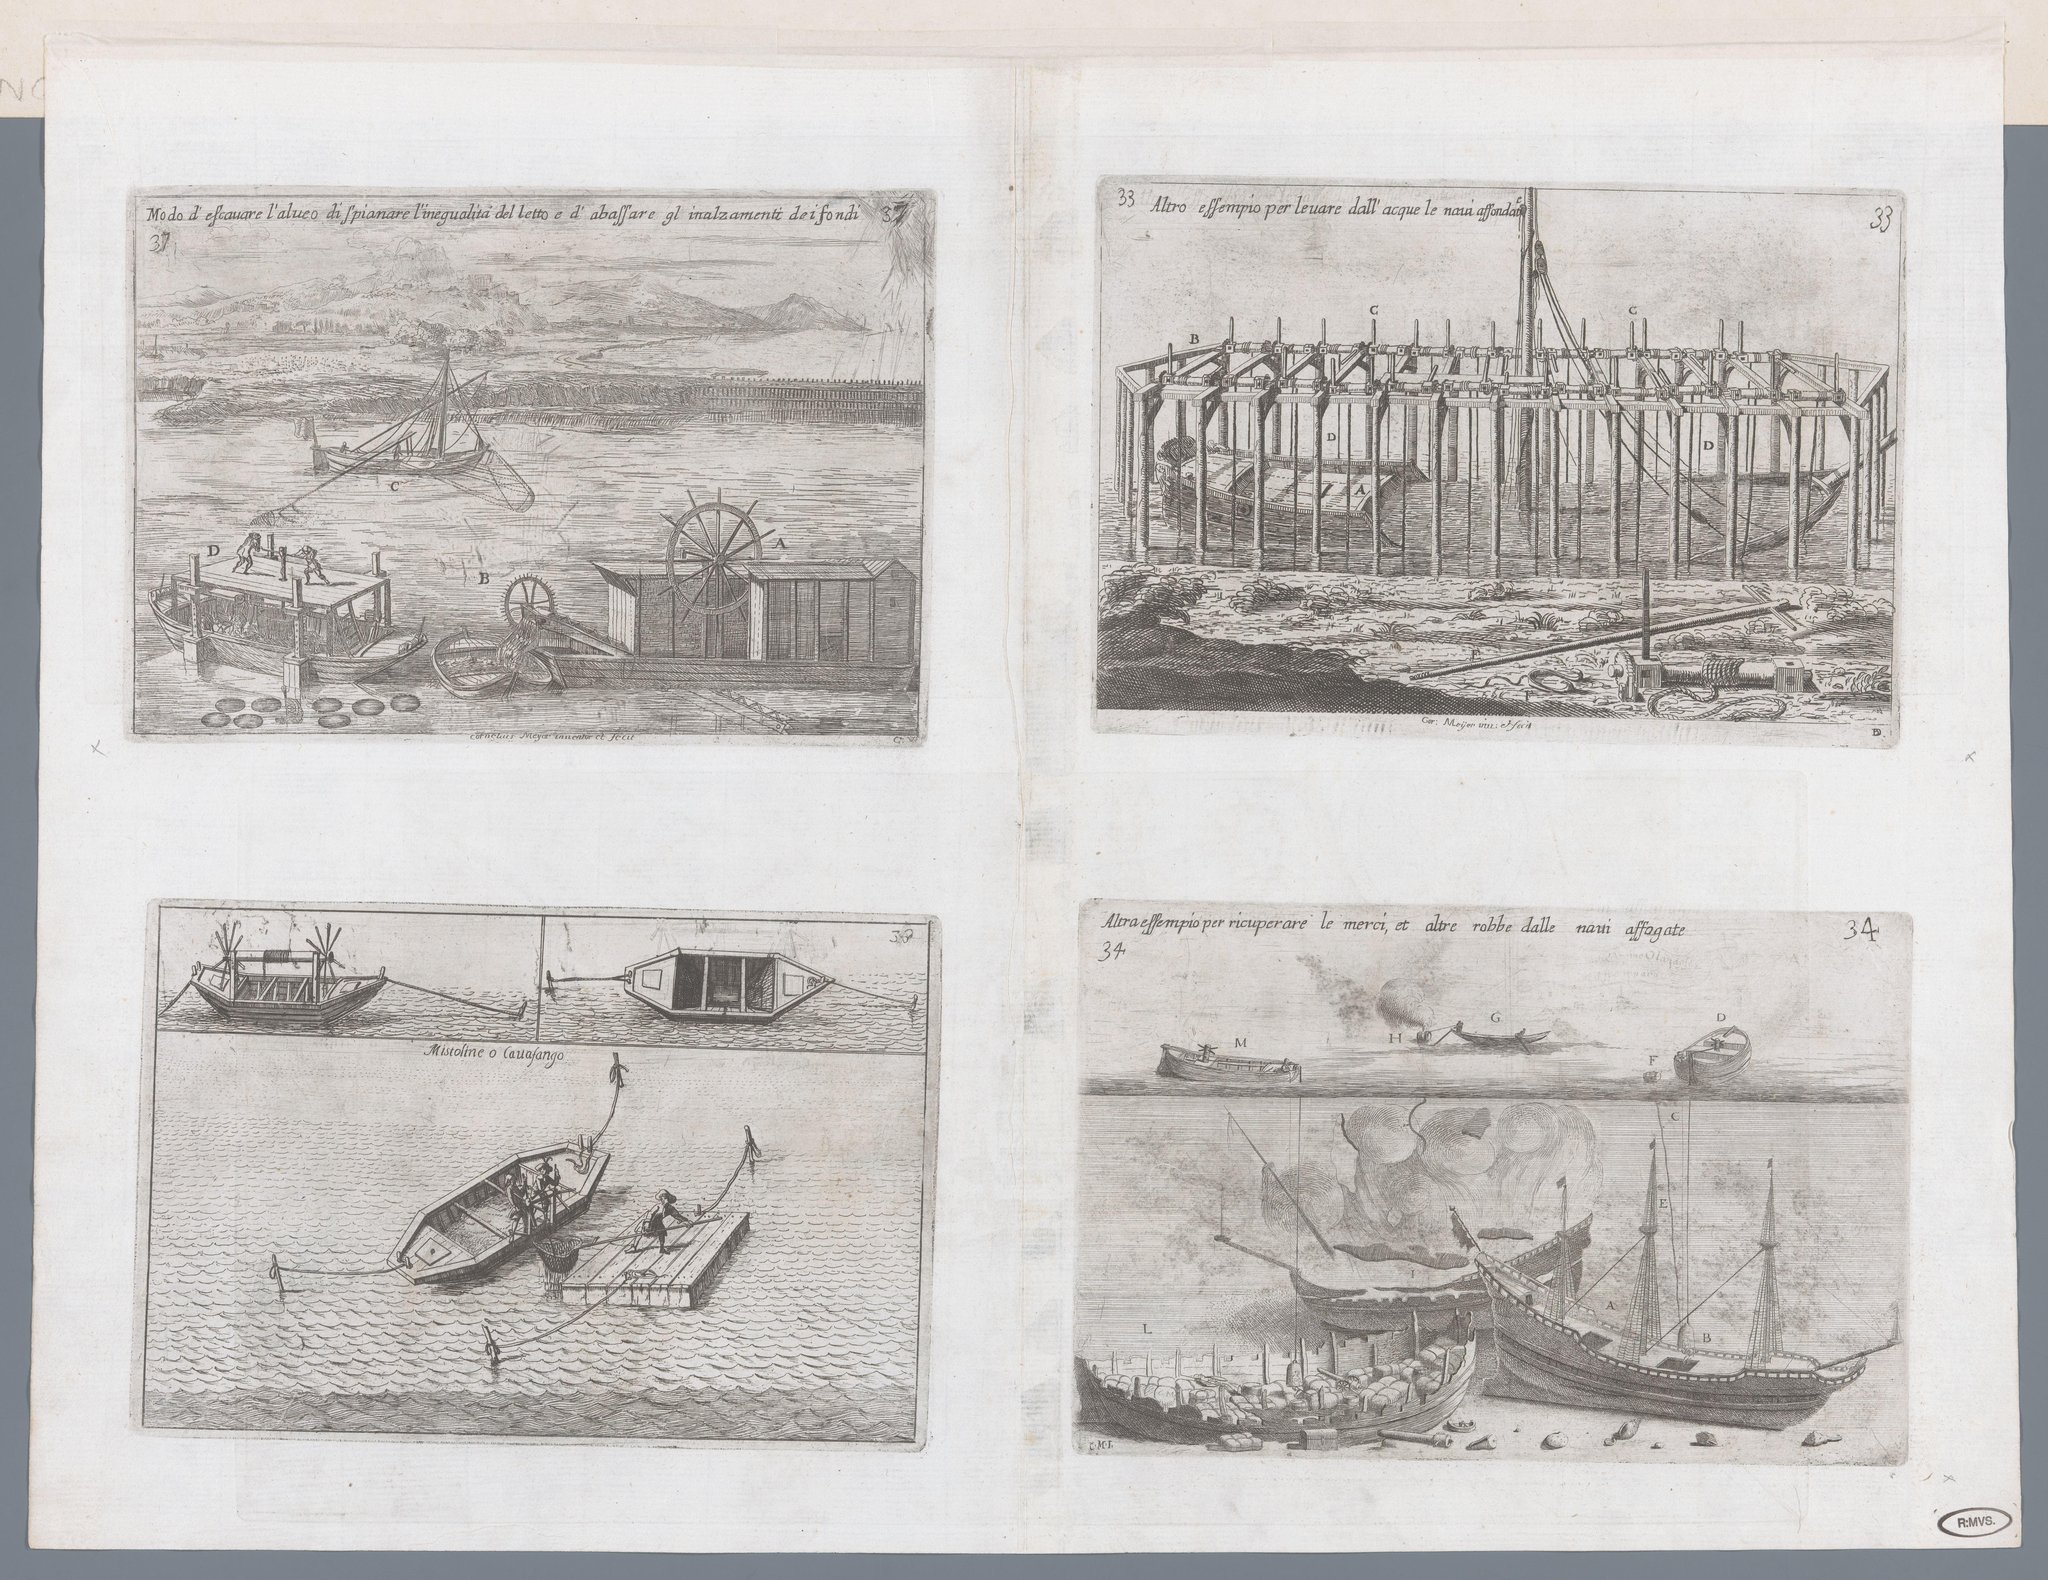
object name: print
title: Vier voorstellingen van schepen en waterbouwkundige installaties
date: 1683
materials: paper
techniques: drypoint, etching, intaglio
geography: rome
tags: river, maps of cities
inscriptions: collector's mark: Lugt 2228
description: Prenten mogelijk uit: L'arte di rendere i fiumi navigabili, in varij modi, con altre nuove inventioni, e varij altri segreti. Rome: Giovanni Giacomo Komarek, 1696. De prenten zijn eerst gedrukt in: Meijer, Cornelis. Arte di restituire à Roma la tralasciata navigatione del suo Teuere. Rome: Lazarri Varese, eerste druk 1683.